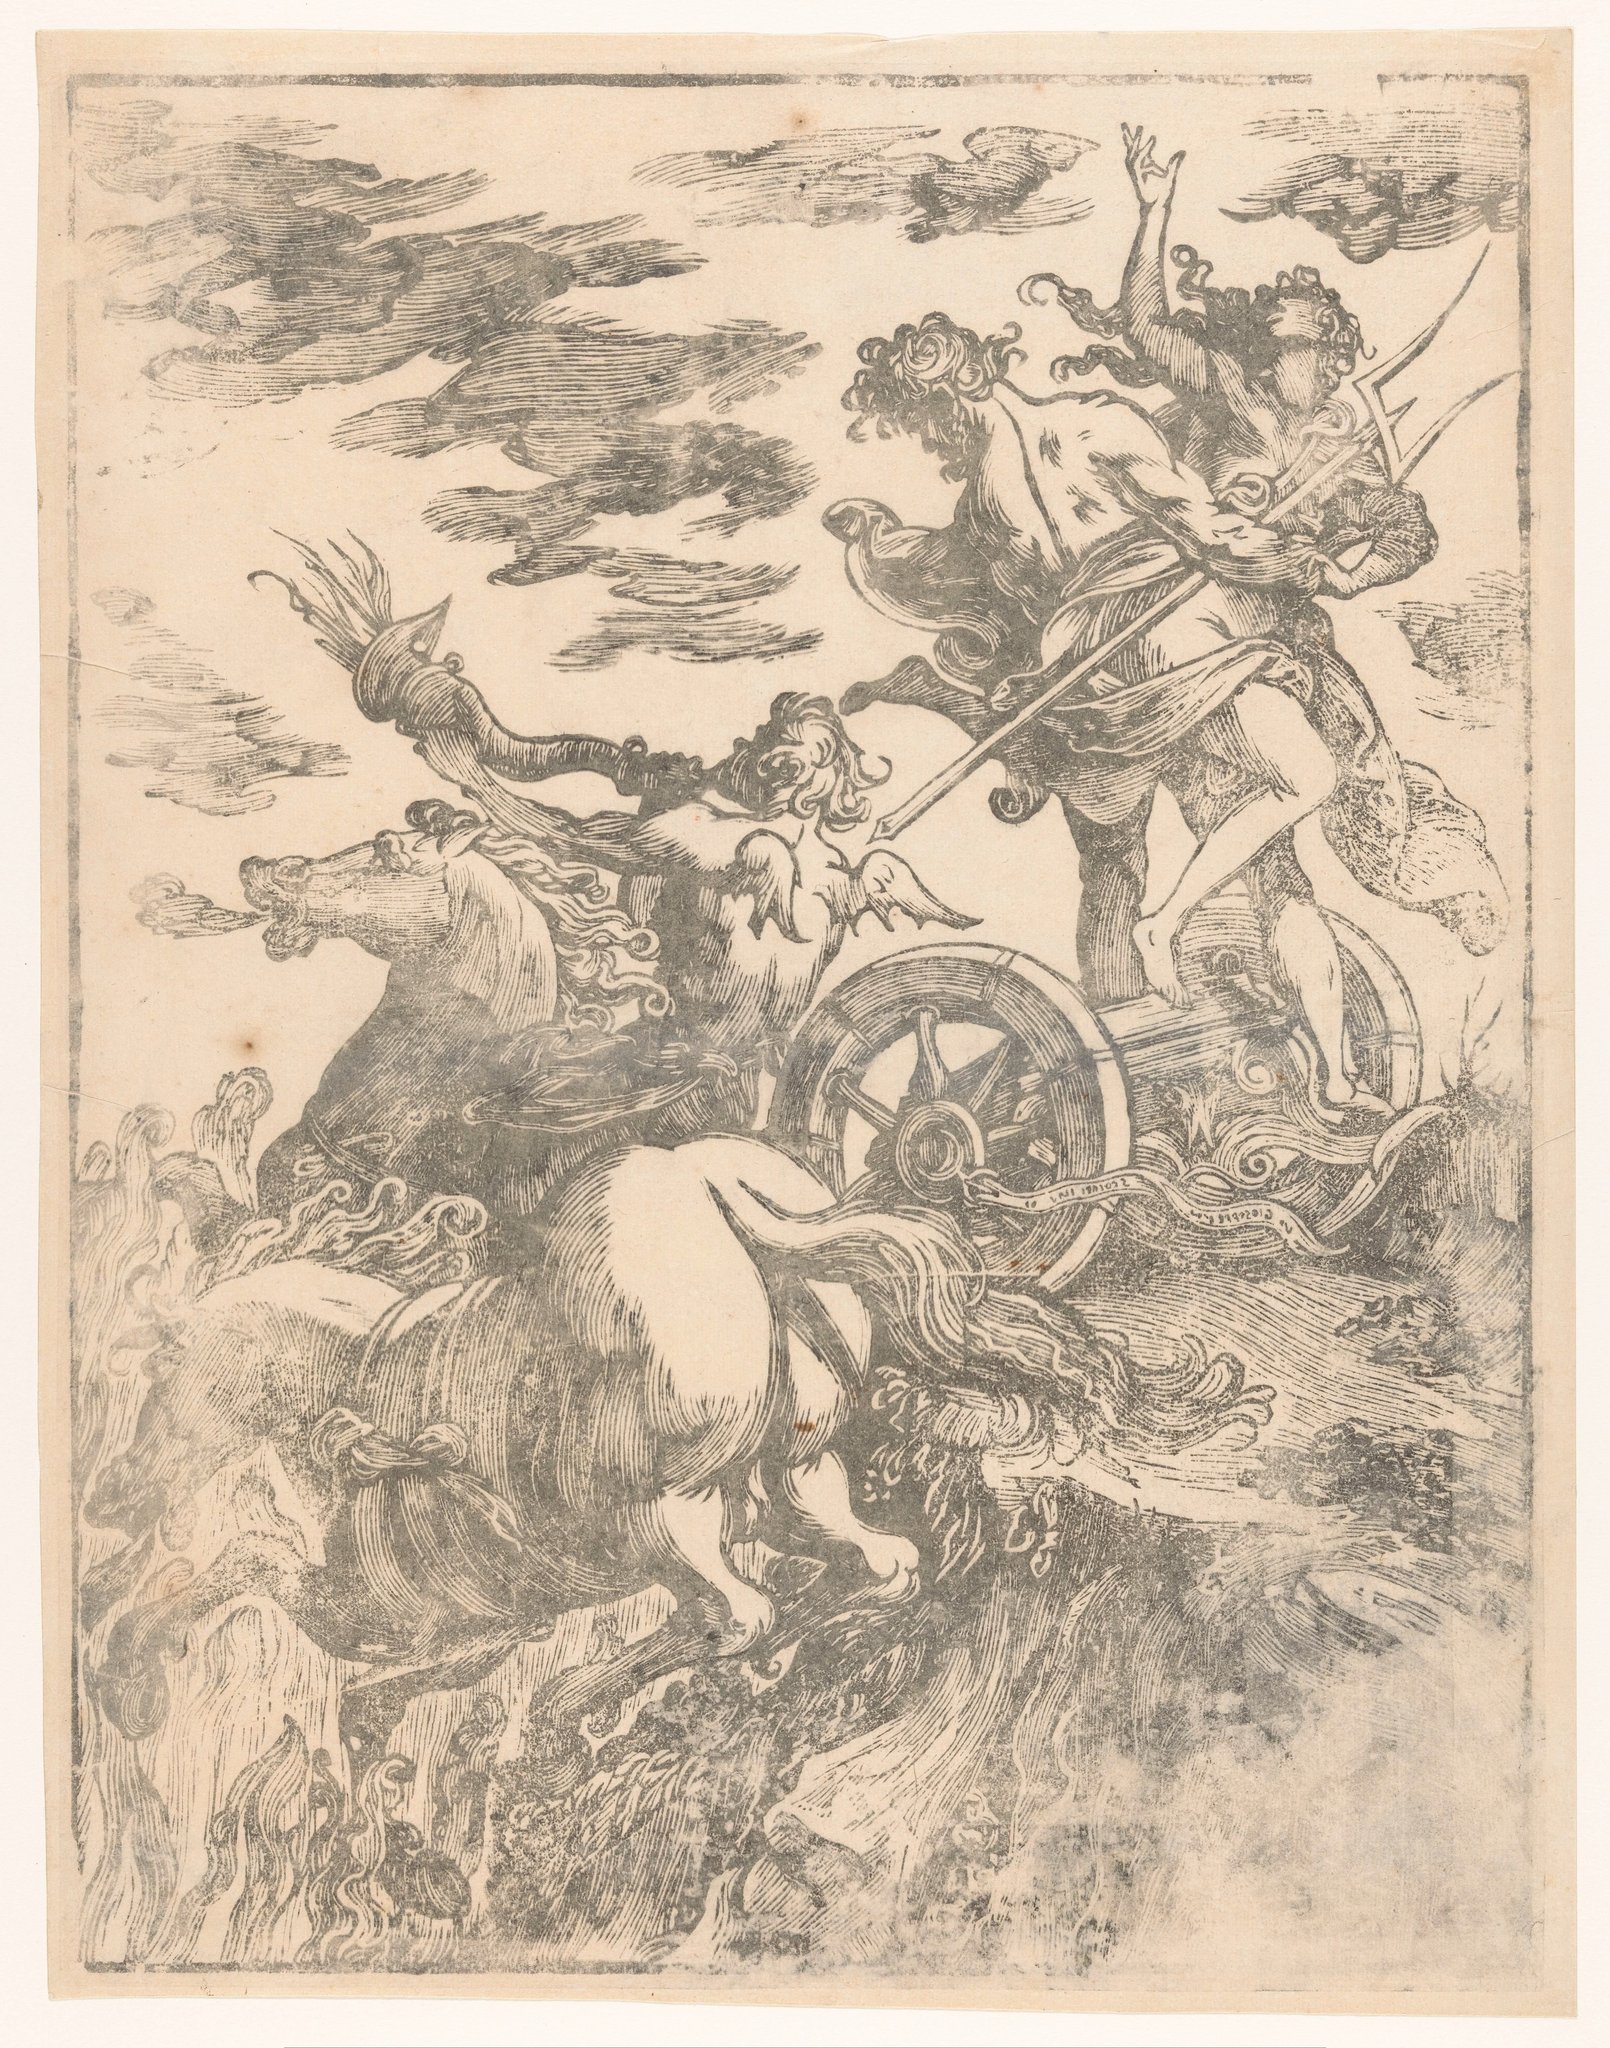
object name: print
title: Roof van Proserpina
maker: giuseppe scolari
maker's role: painter, print maker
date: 1550-1600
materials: paper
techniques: printmaking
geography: italy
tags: the rape of proserpina (by pluto in his chariot); possibly with diana and minerva trying to rescue her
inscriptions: collector's mark: Lugt 240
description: Proserpina wordt door Pluto naar de onderwereld ontvoerd. Nadat Pluto haar op zijn wagen sleurde, liet hij in de aarde een grote kloof ontstaan.